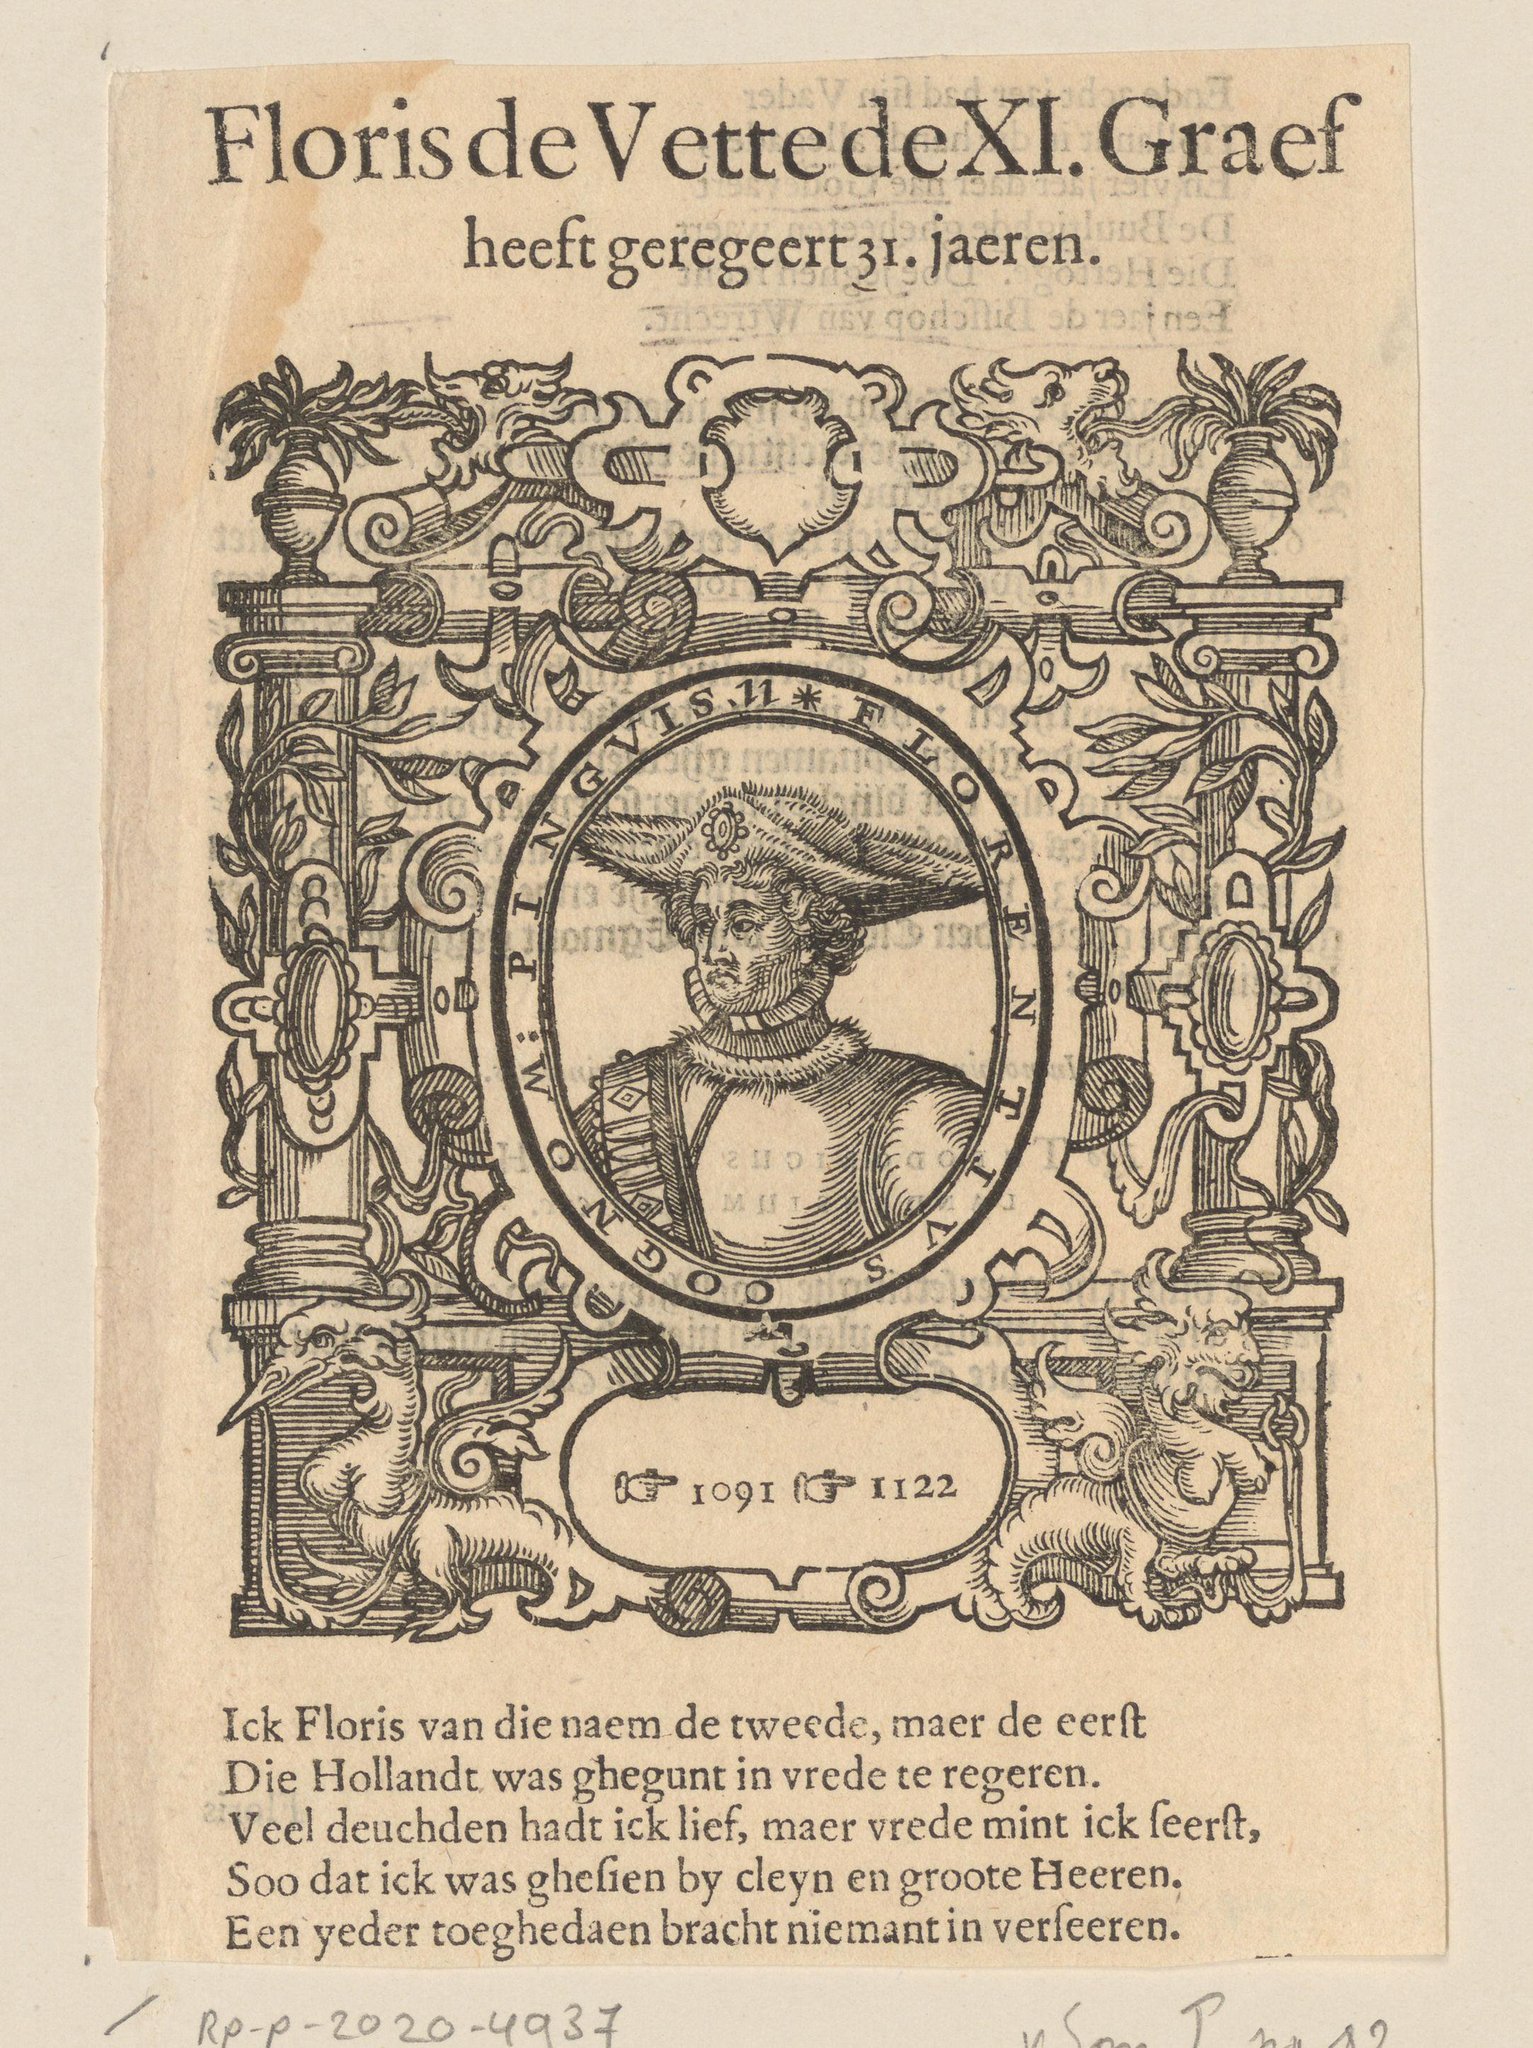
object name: print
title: Portret van Floris II, graaf van Holland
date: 1636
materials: paper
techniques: letterpress printing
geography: northern netherlands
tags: lion's head ~ ornament, historical persons, ruler, sovereign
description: Prent uit: Scriverius, Petrus. Beschrivinge van Out Batavien (...). Amsterdam: Jan Cloppenburg, 1636. Prent met andere omlijsting gebruikt in eerdere editie van het werk uit 1606.